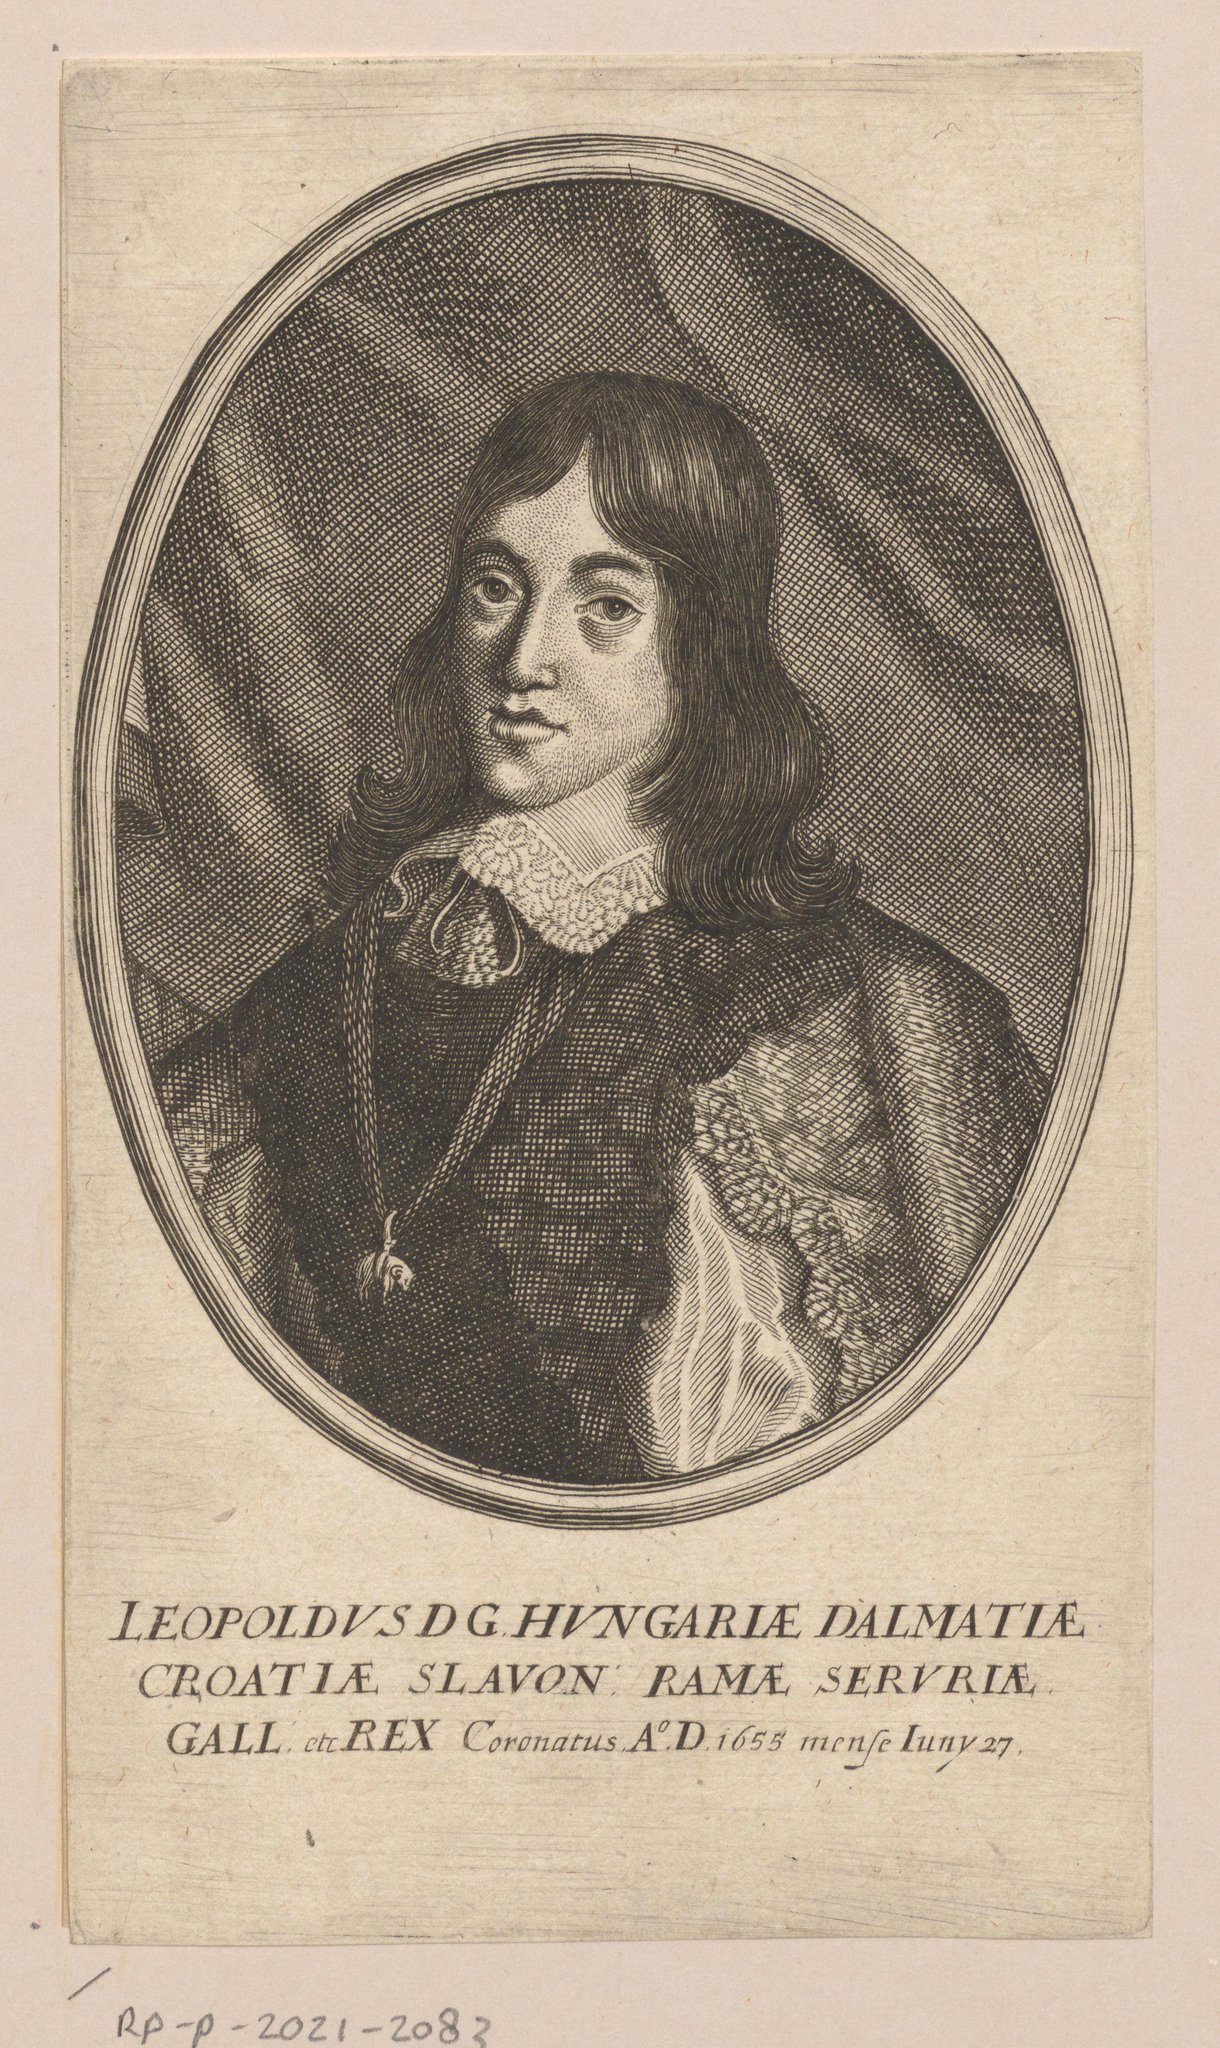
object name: print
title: Portret van Leopold I als koning van Hongarije en Bohemen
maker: Anonymous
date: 1655-1657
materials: paper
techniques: engraving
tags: vienna, leopold i (keizer van duitsland), historical persons, knighthood order of the golden fleece - insignia of a knighthood order, e.g.: badge, chain (with name of order), king